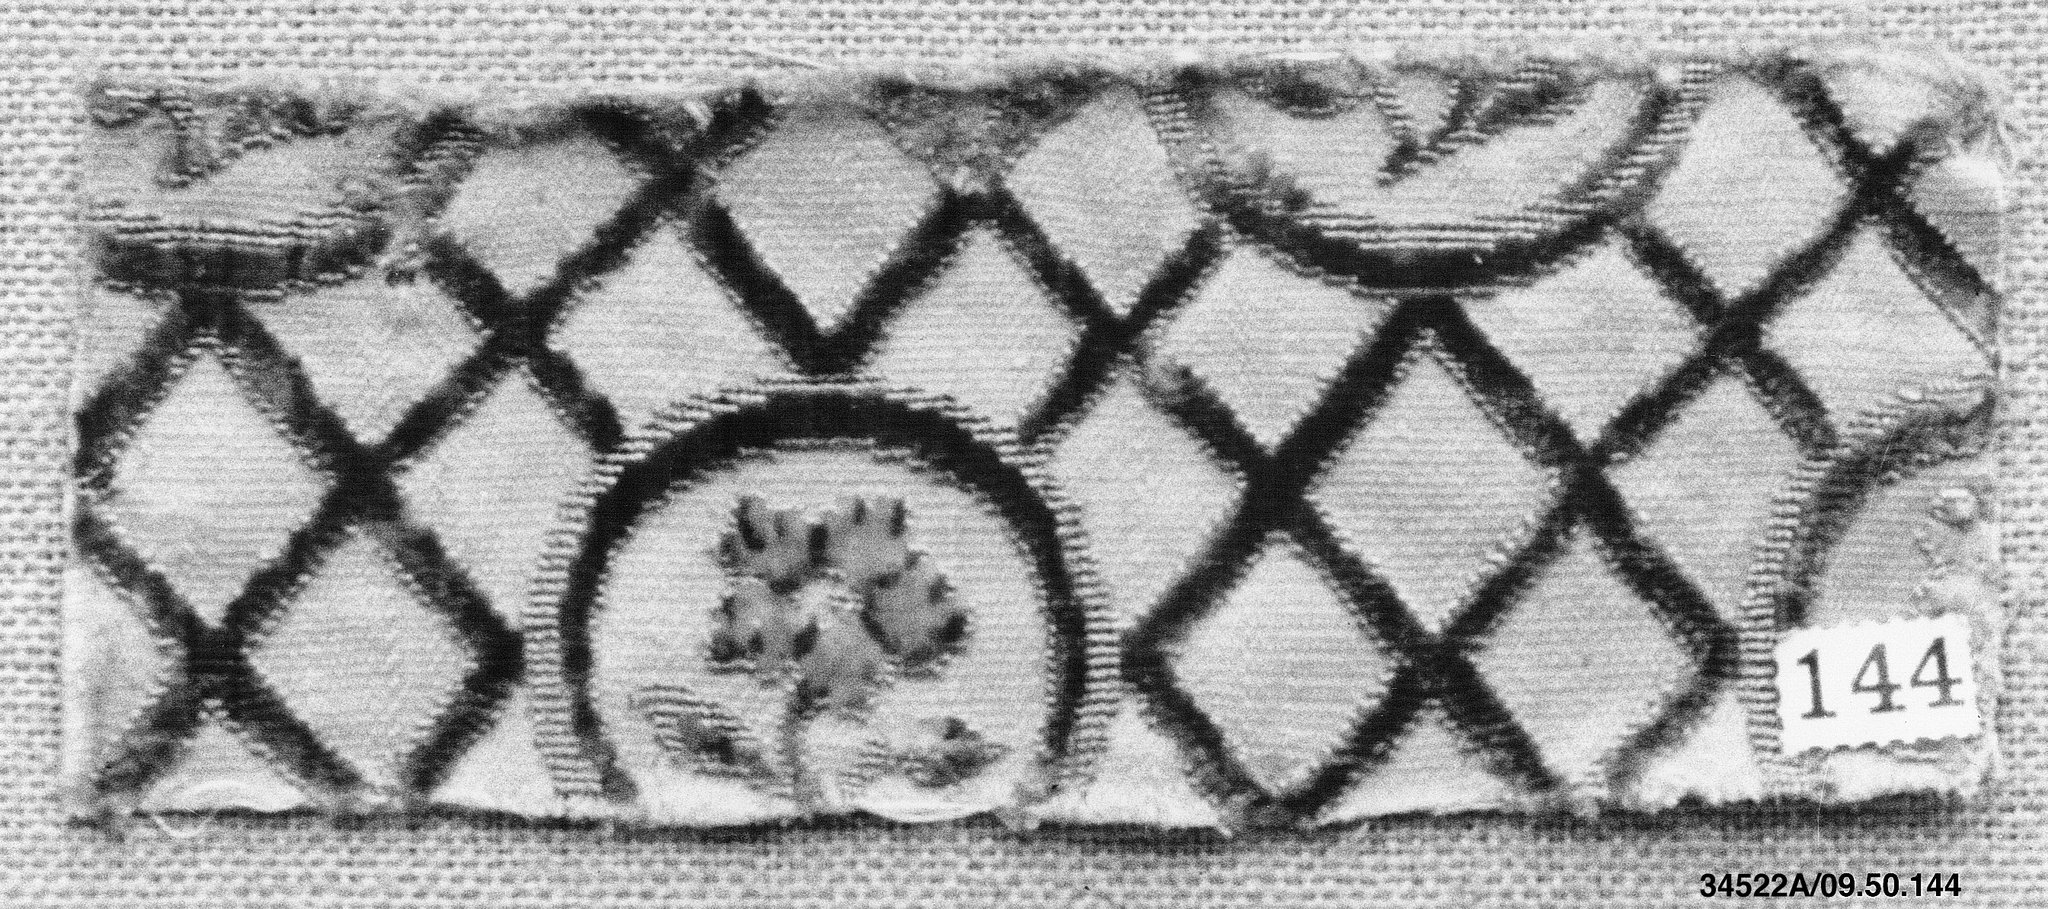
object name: piece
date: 1701-1800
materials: silk